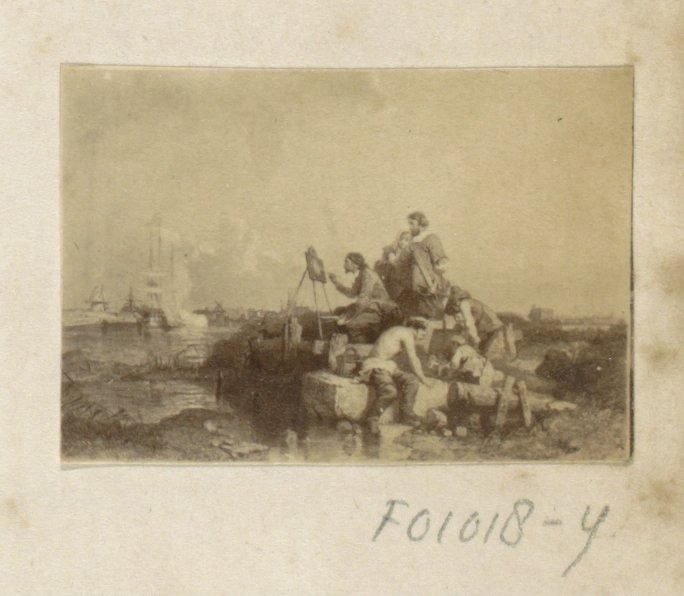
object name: reproduction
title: Fotoreproductie van (vermoedelijk) een schilderij met een schilderstafereel in de openlucht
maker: Anonymous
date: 1860-1870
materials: paper, photographic support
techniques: albumen print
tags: painter at work, in his studio - cc - out of doors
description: Onderdeel van Engels familiealbum met foto's van personen, reizen, cricket en kunstwerken.